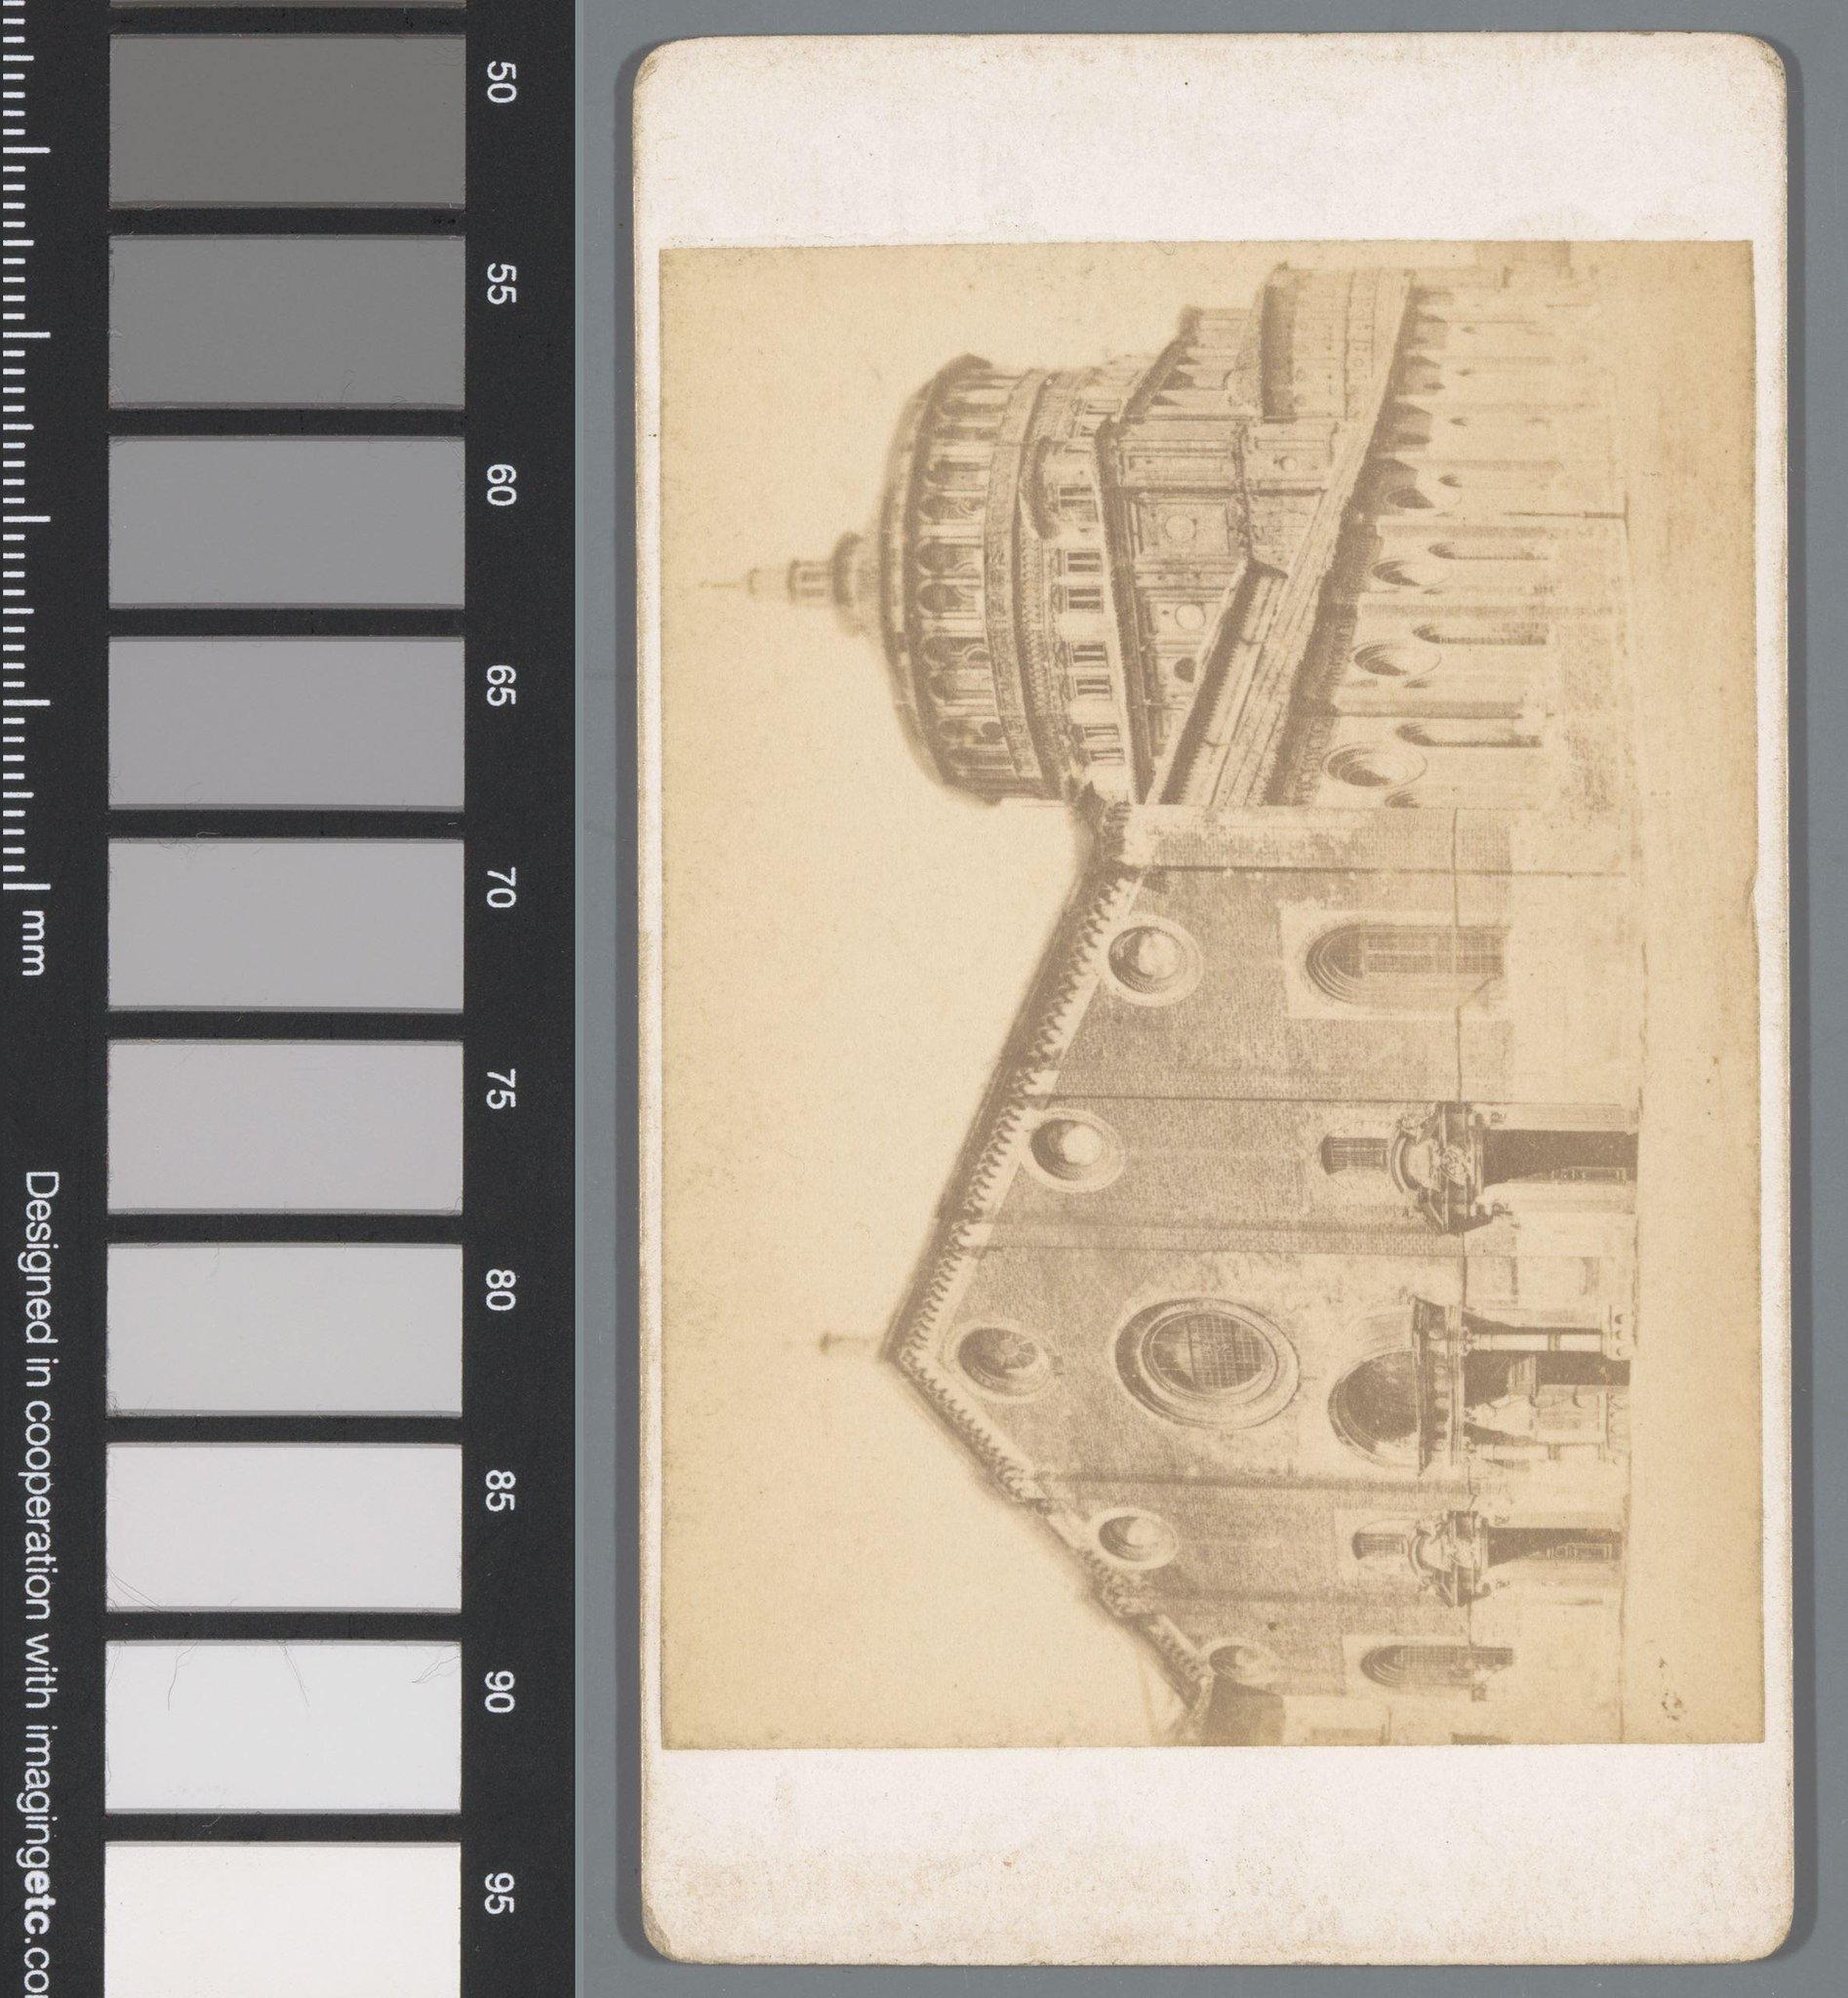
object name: photograph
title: Sta. Maria de Grazie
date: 1869-1888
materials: cardboard, paper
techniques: albumen print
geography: milan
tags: church (exterior)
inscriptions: inscription: ‘Fotografia/ dei/ pittori/ Spagliardi e Silo/ Corso di Porta Veenzia, 11/ Milano/ Piano terreno con grande giardino.’